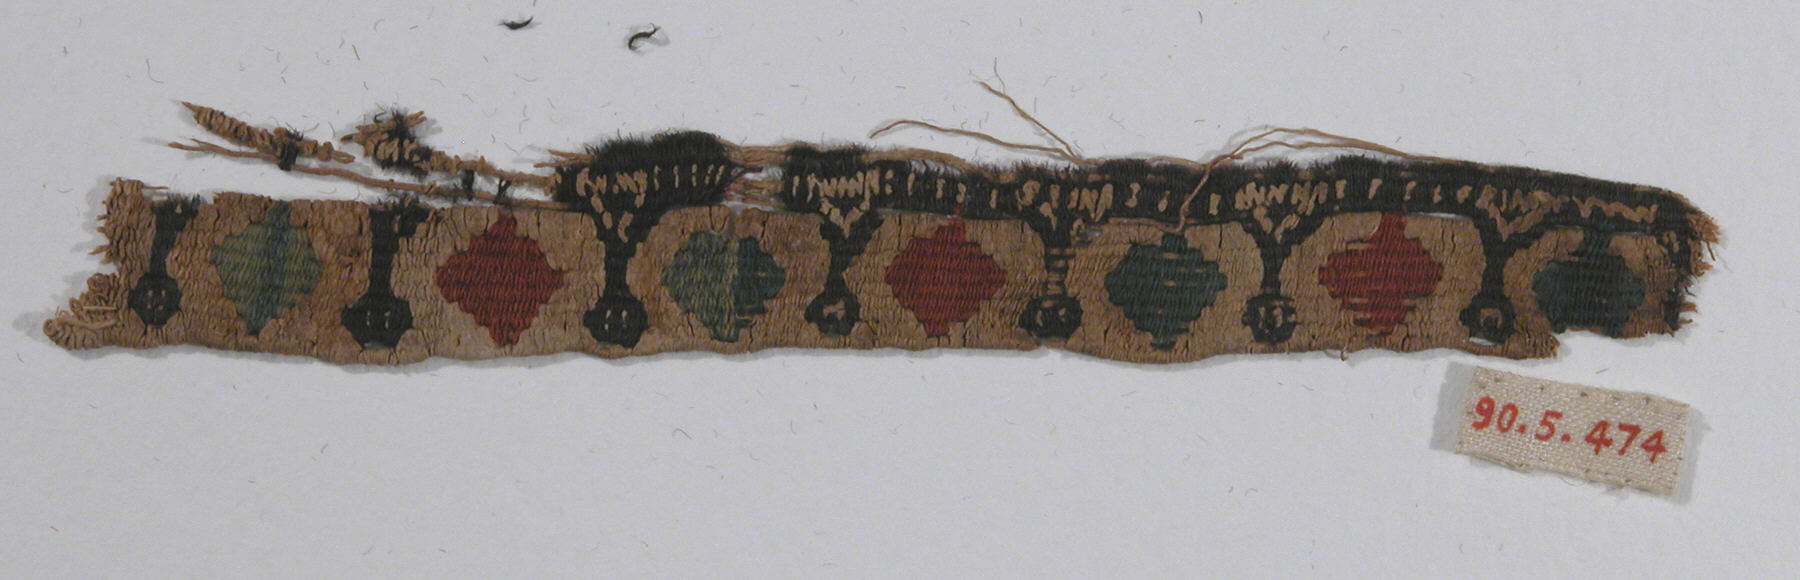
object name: textile fragment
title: Fragment of Neck Border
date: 401-500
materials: linen, wool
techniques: weave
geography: egypt